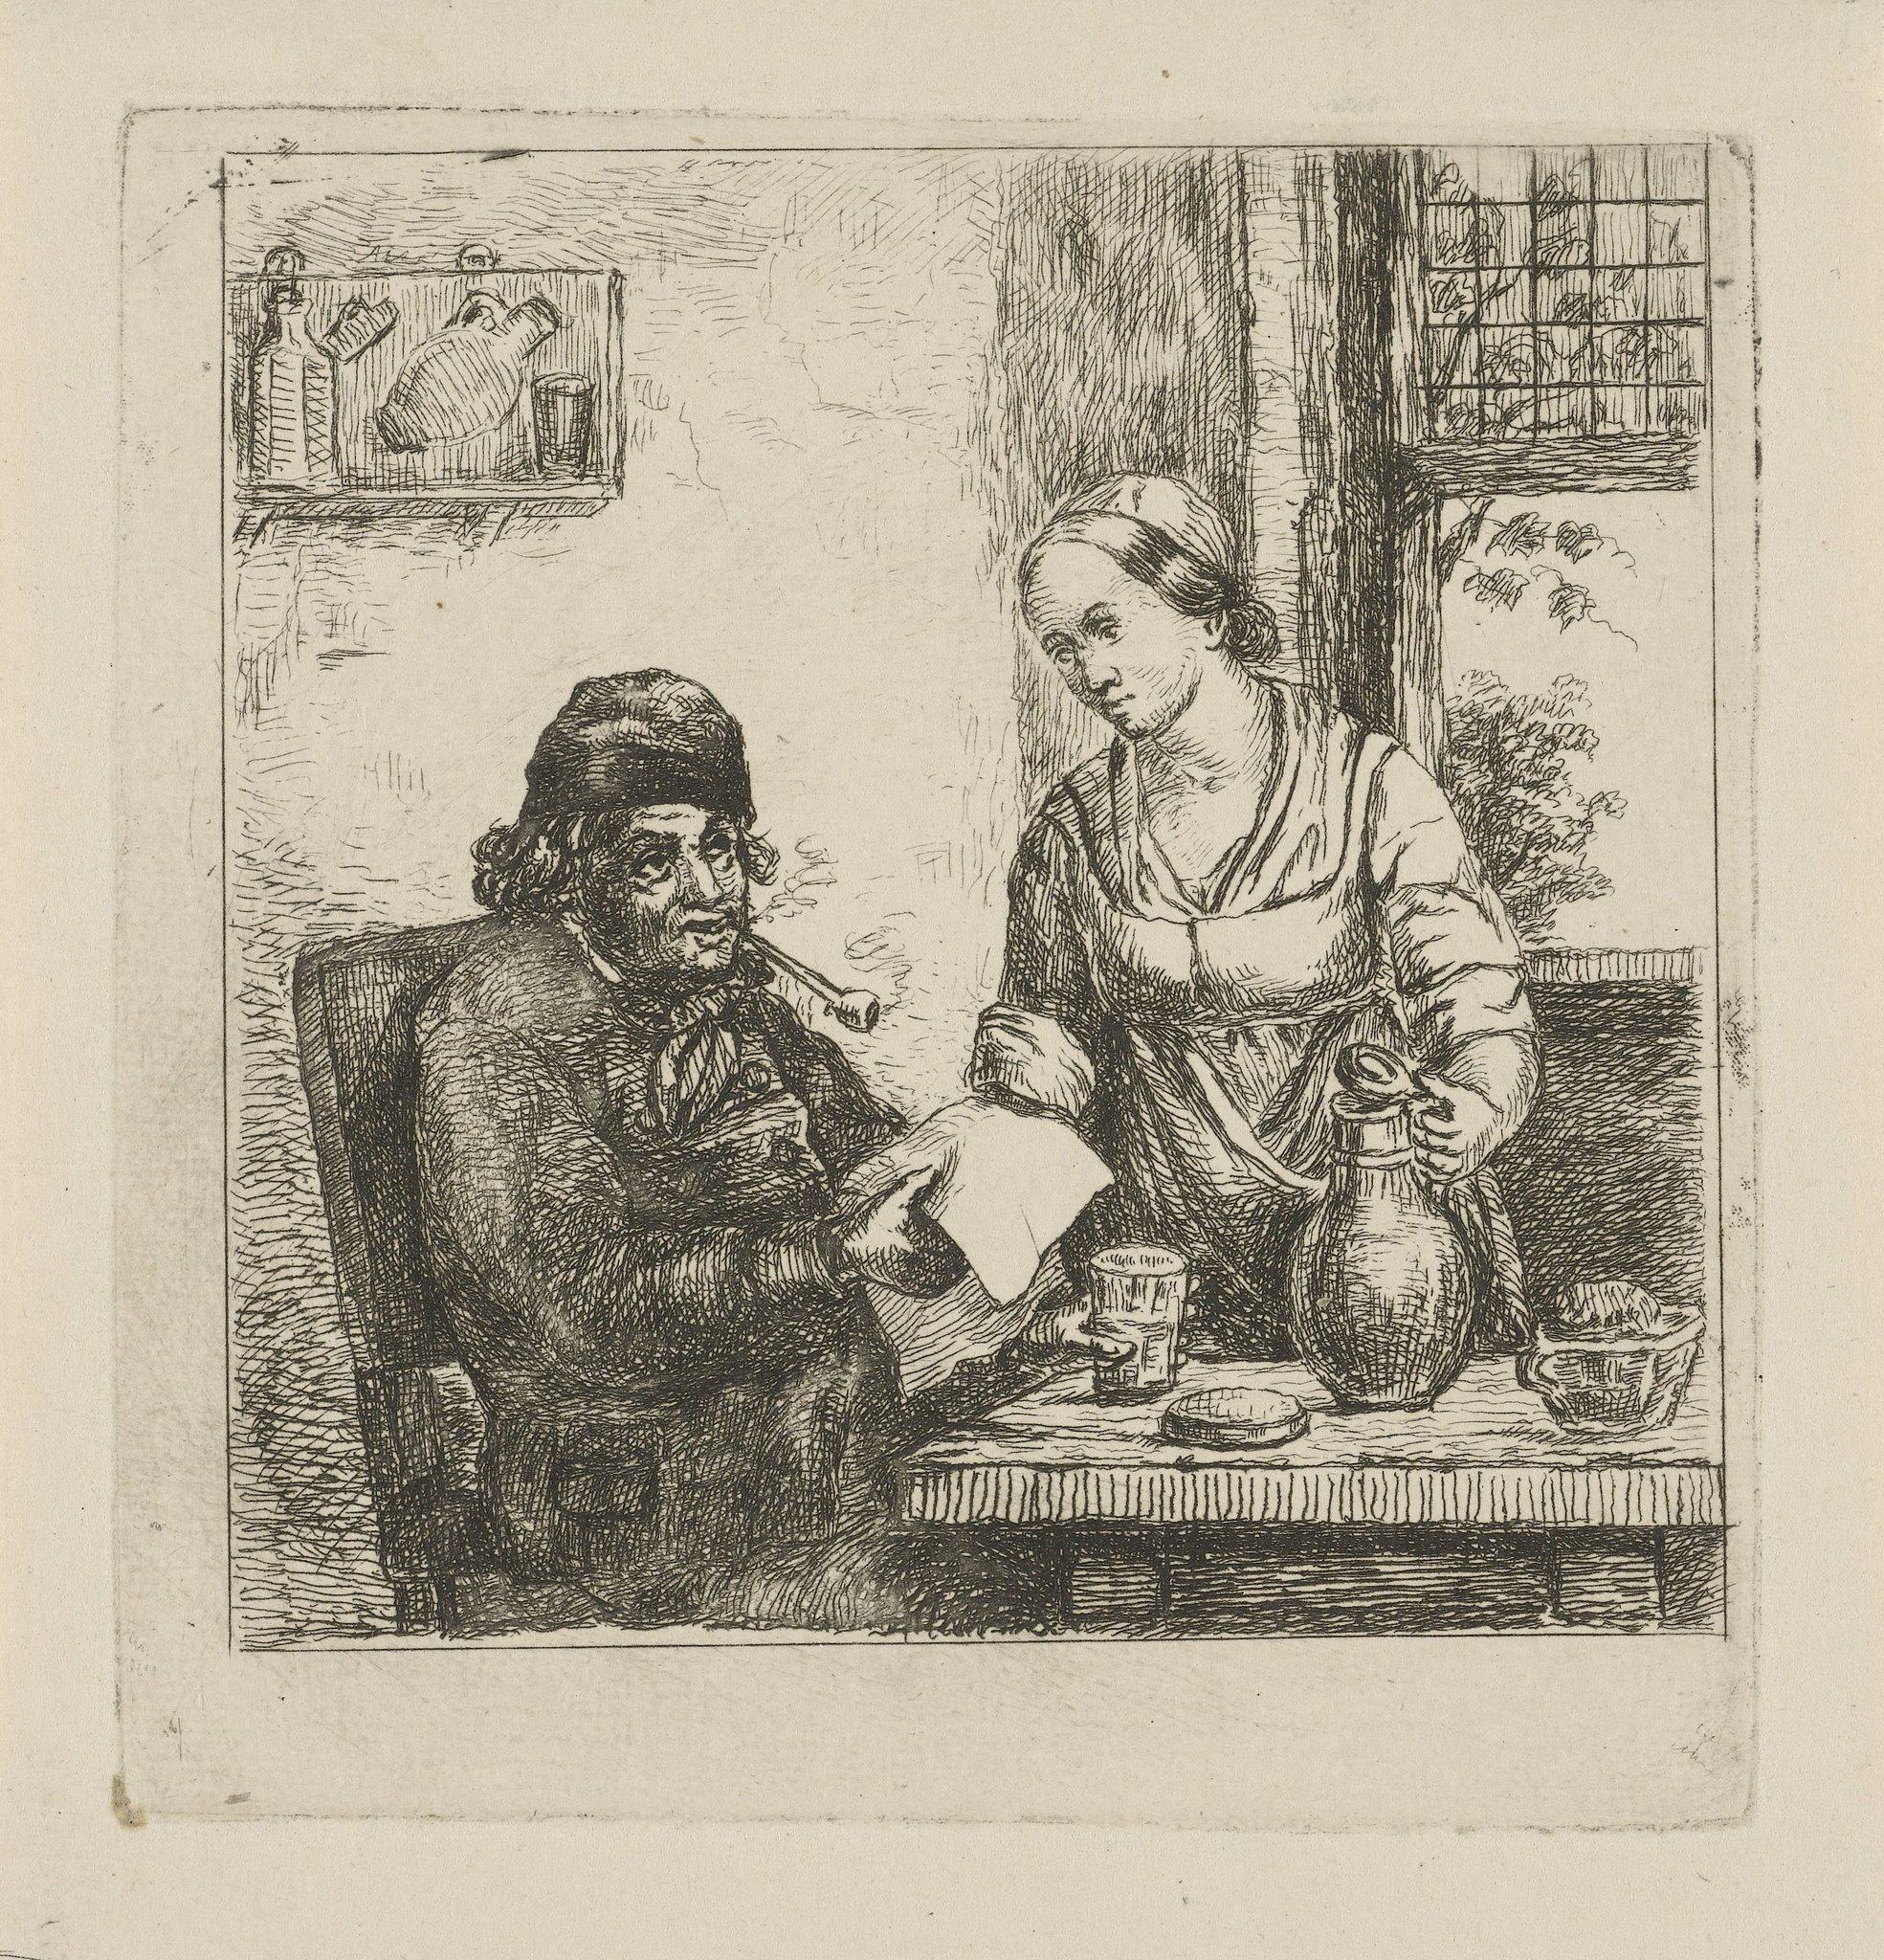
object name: print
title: Interieur met man en vrouw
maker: david van der kellen (1804-1879)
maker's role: die cutter, draughtsman, print maker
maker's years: 1804-1879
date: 1814-1878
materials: paper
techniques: drypoint, etching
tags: reading, interior of the house, eating and drinking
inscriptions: collector's mark: Lugt 2228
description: Interieur met rokende man aan een tafel en een staande vrouw met kan. Aan de muur hangt een kastje met daarin twee kannen en een beker.